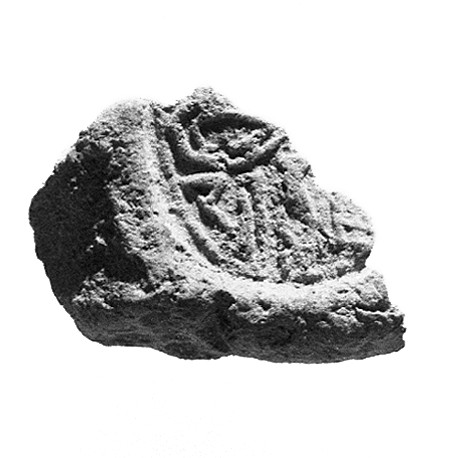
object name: sealing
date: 1981-1640 BCE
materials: mud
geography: egypt